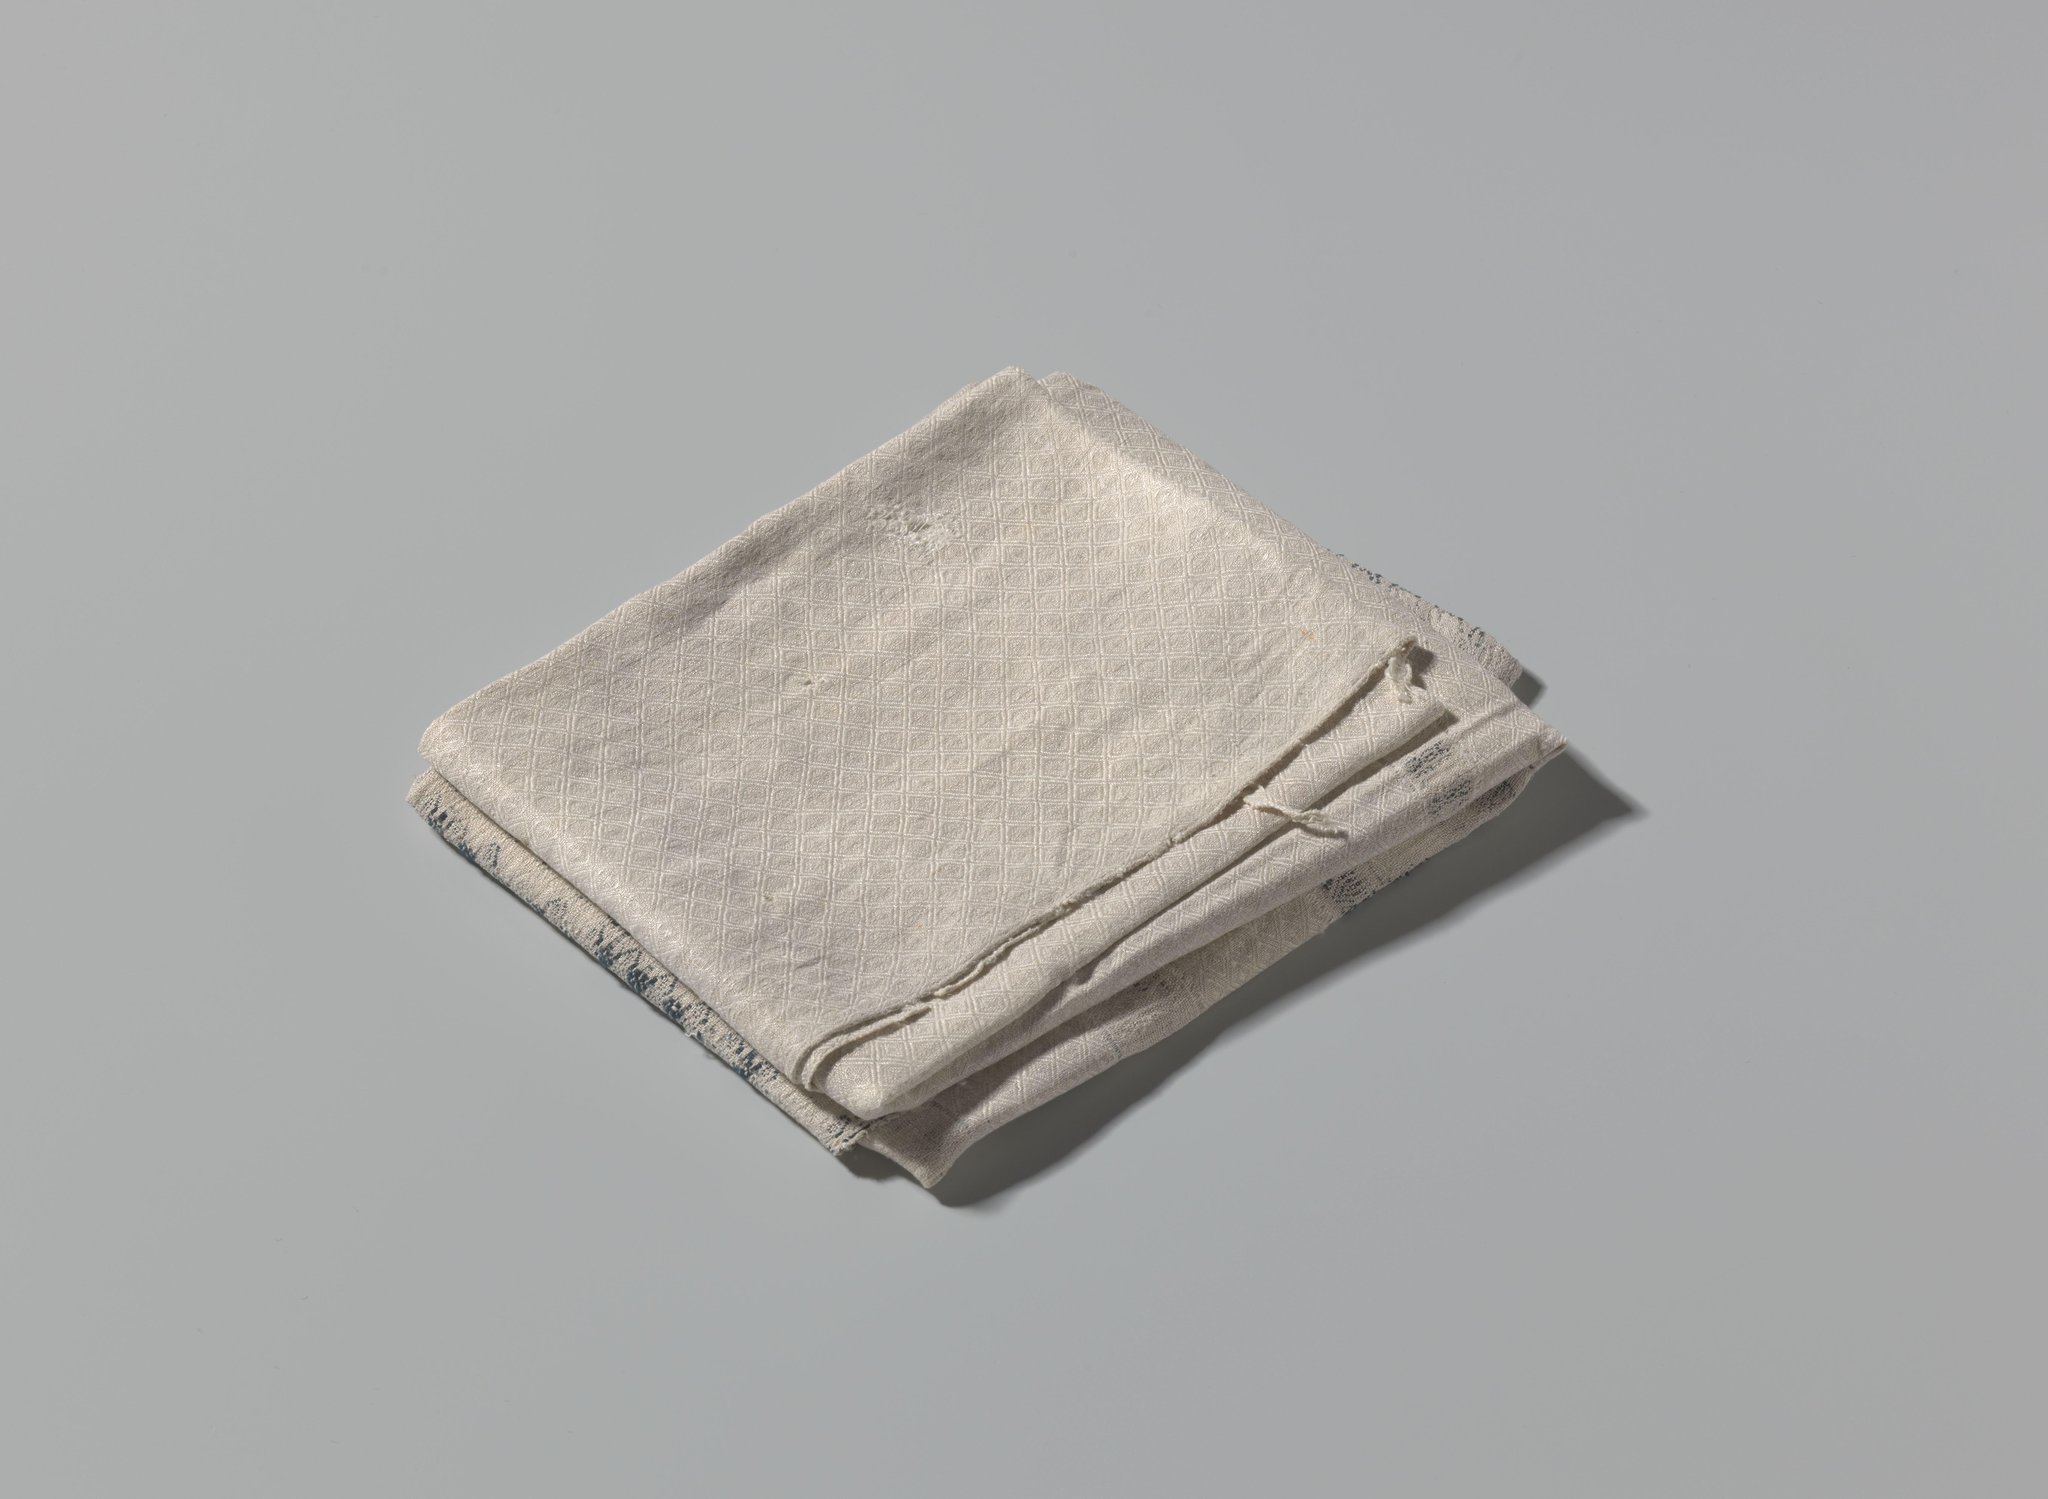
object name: altaardwaal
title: Altaardwaal of handdwaal van linnendamast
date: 1500-1600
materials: linen, wool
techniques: damask, weave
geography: italy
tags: sint odiliënberg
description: Altaardwaal of handdwaal van linnendamast. De dwaal heeft ingeweven of doorgestopte randen van donkerblauwe wol, in geometrische patronen.